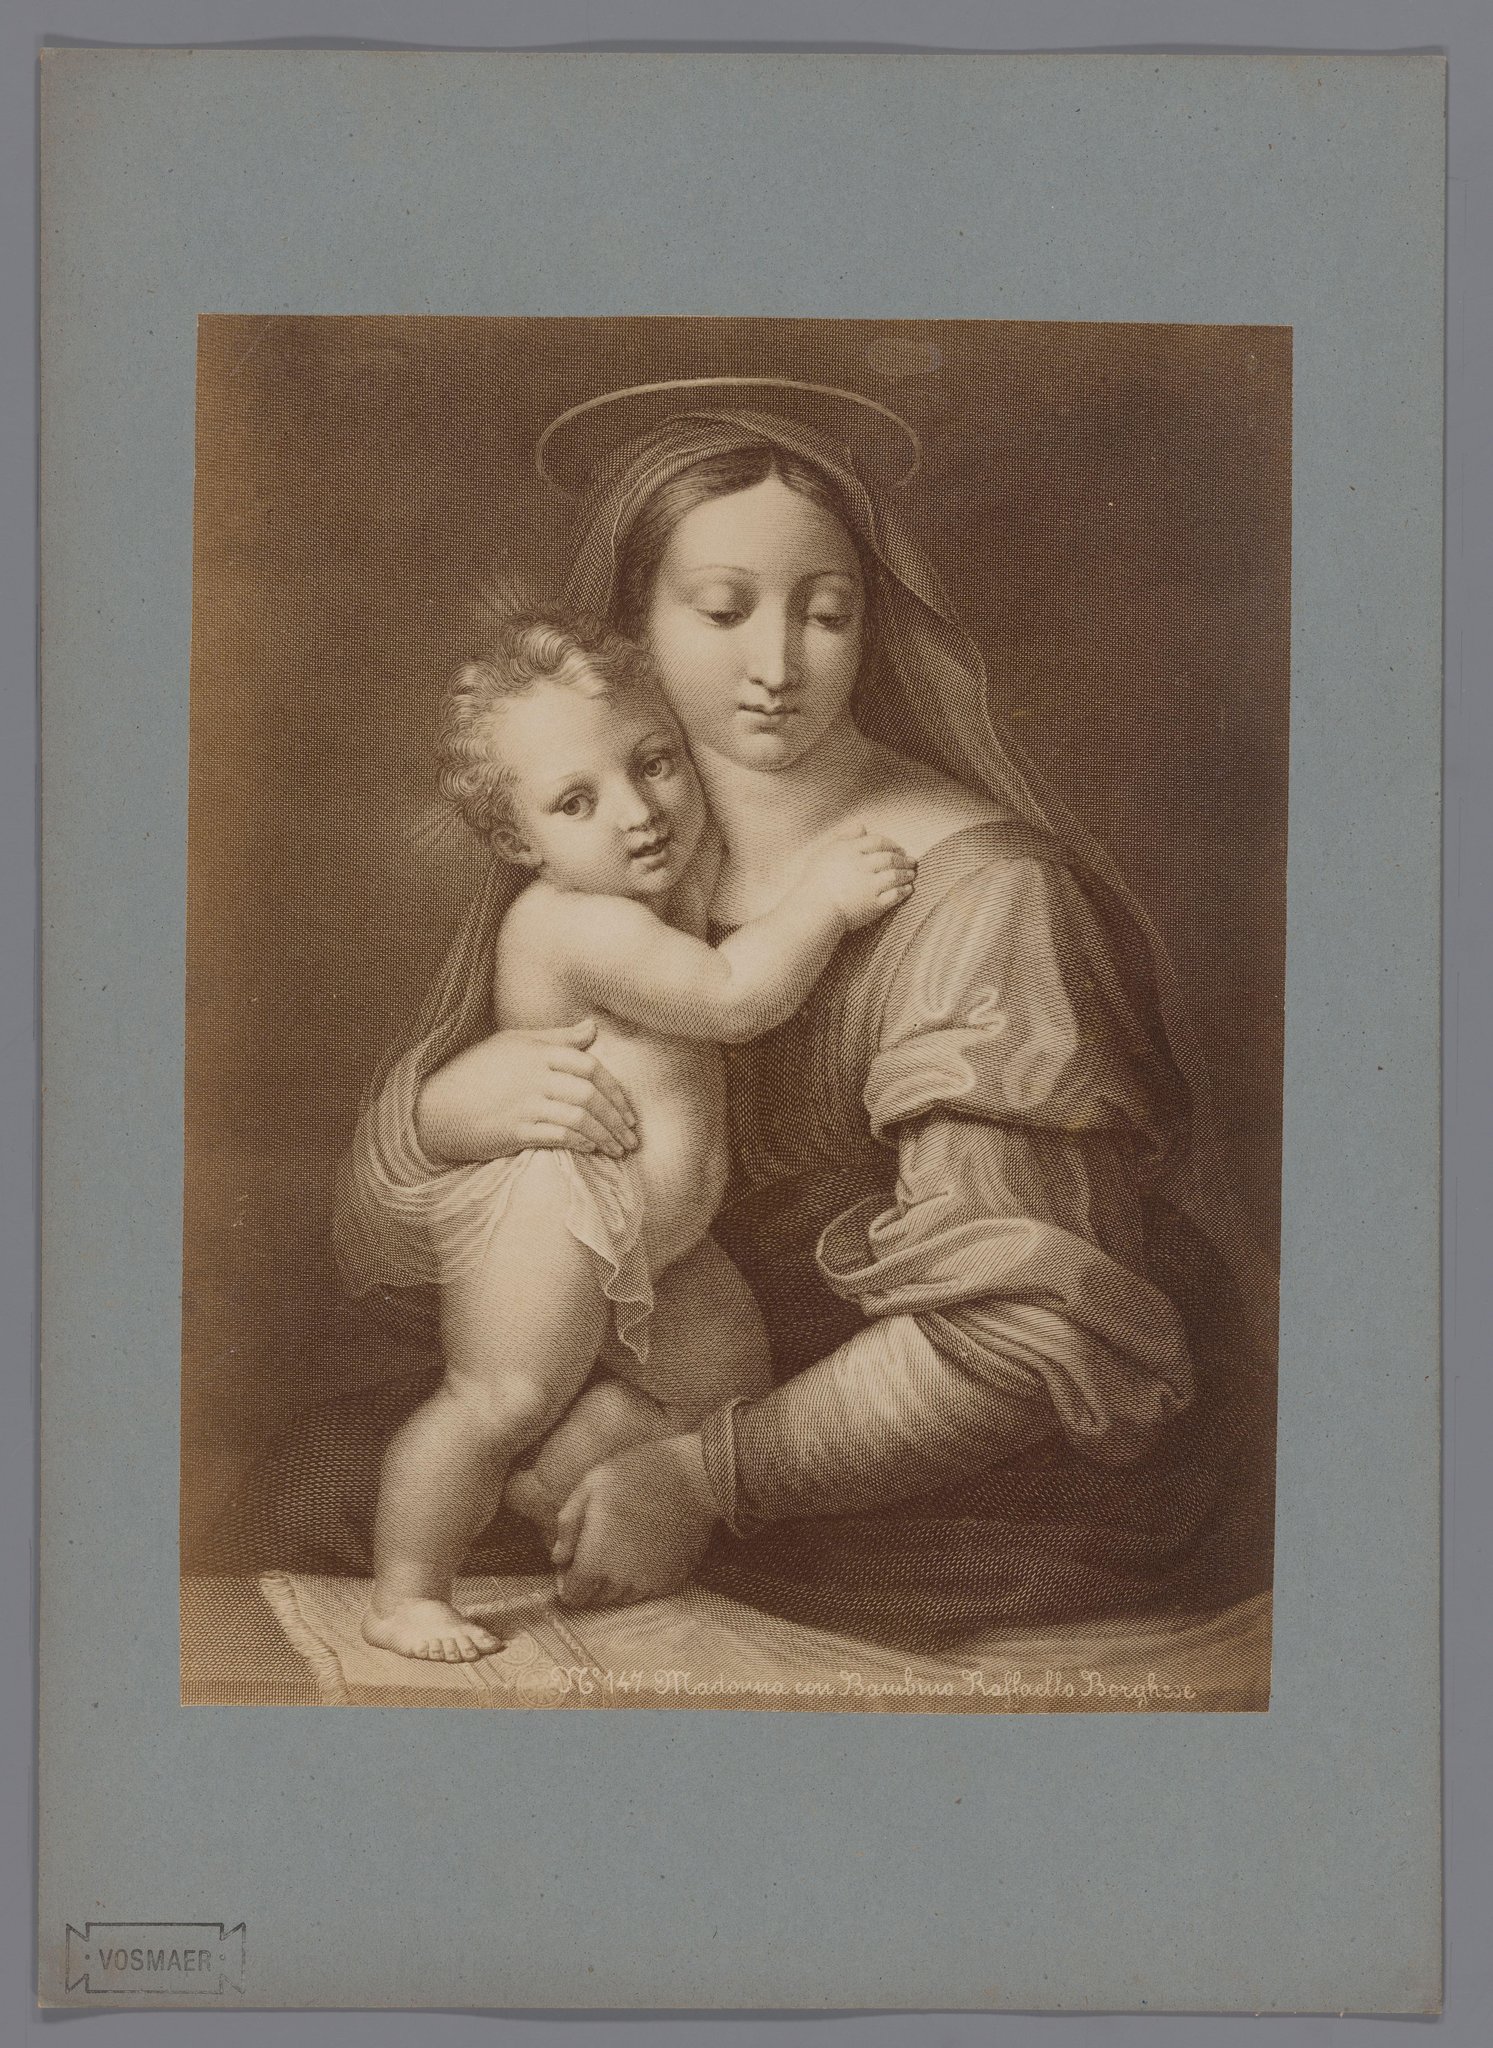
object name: photograph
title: Madonna con Bambino Raffaello Borghese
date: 1851-1900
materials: cardboard, paper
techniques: albumen print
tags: drawing, sketch, madonna: i.e. mary with the christ-child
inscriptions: number: ‘No. 147’, collector's mark: ‘VOSMAER’